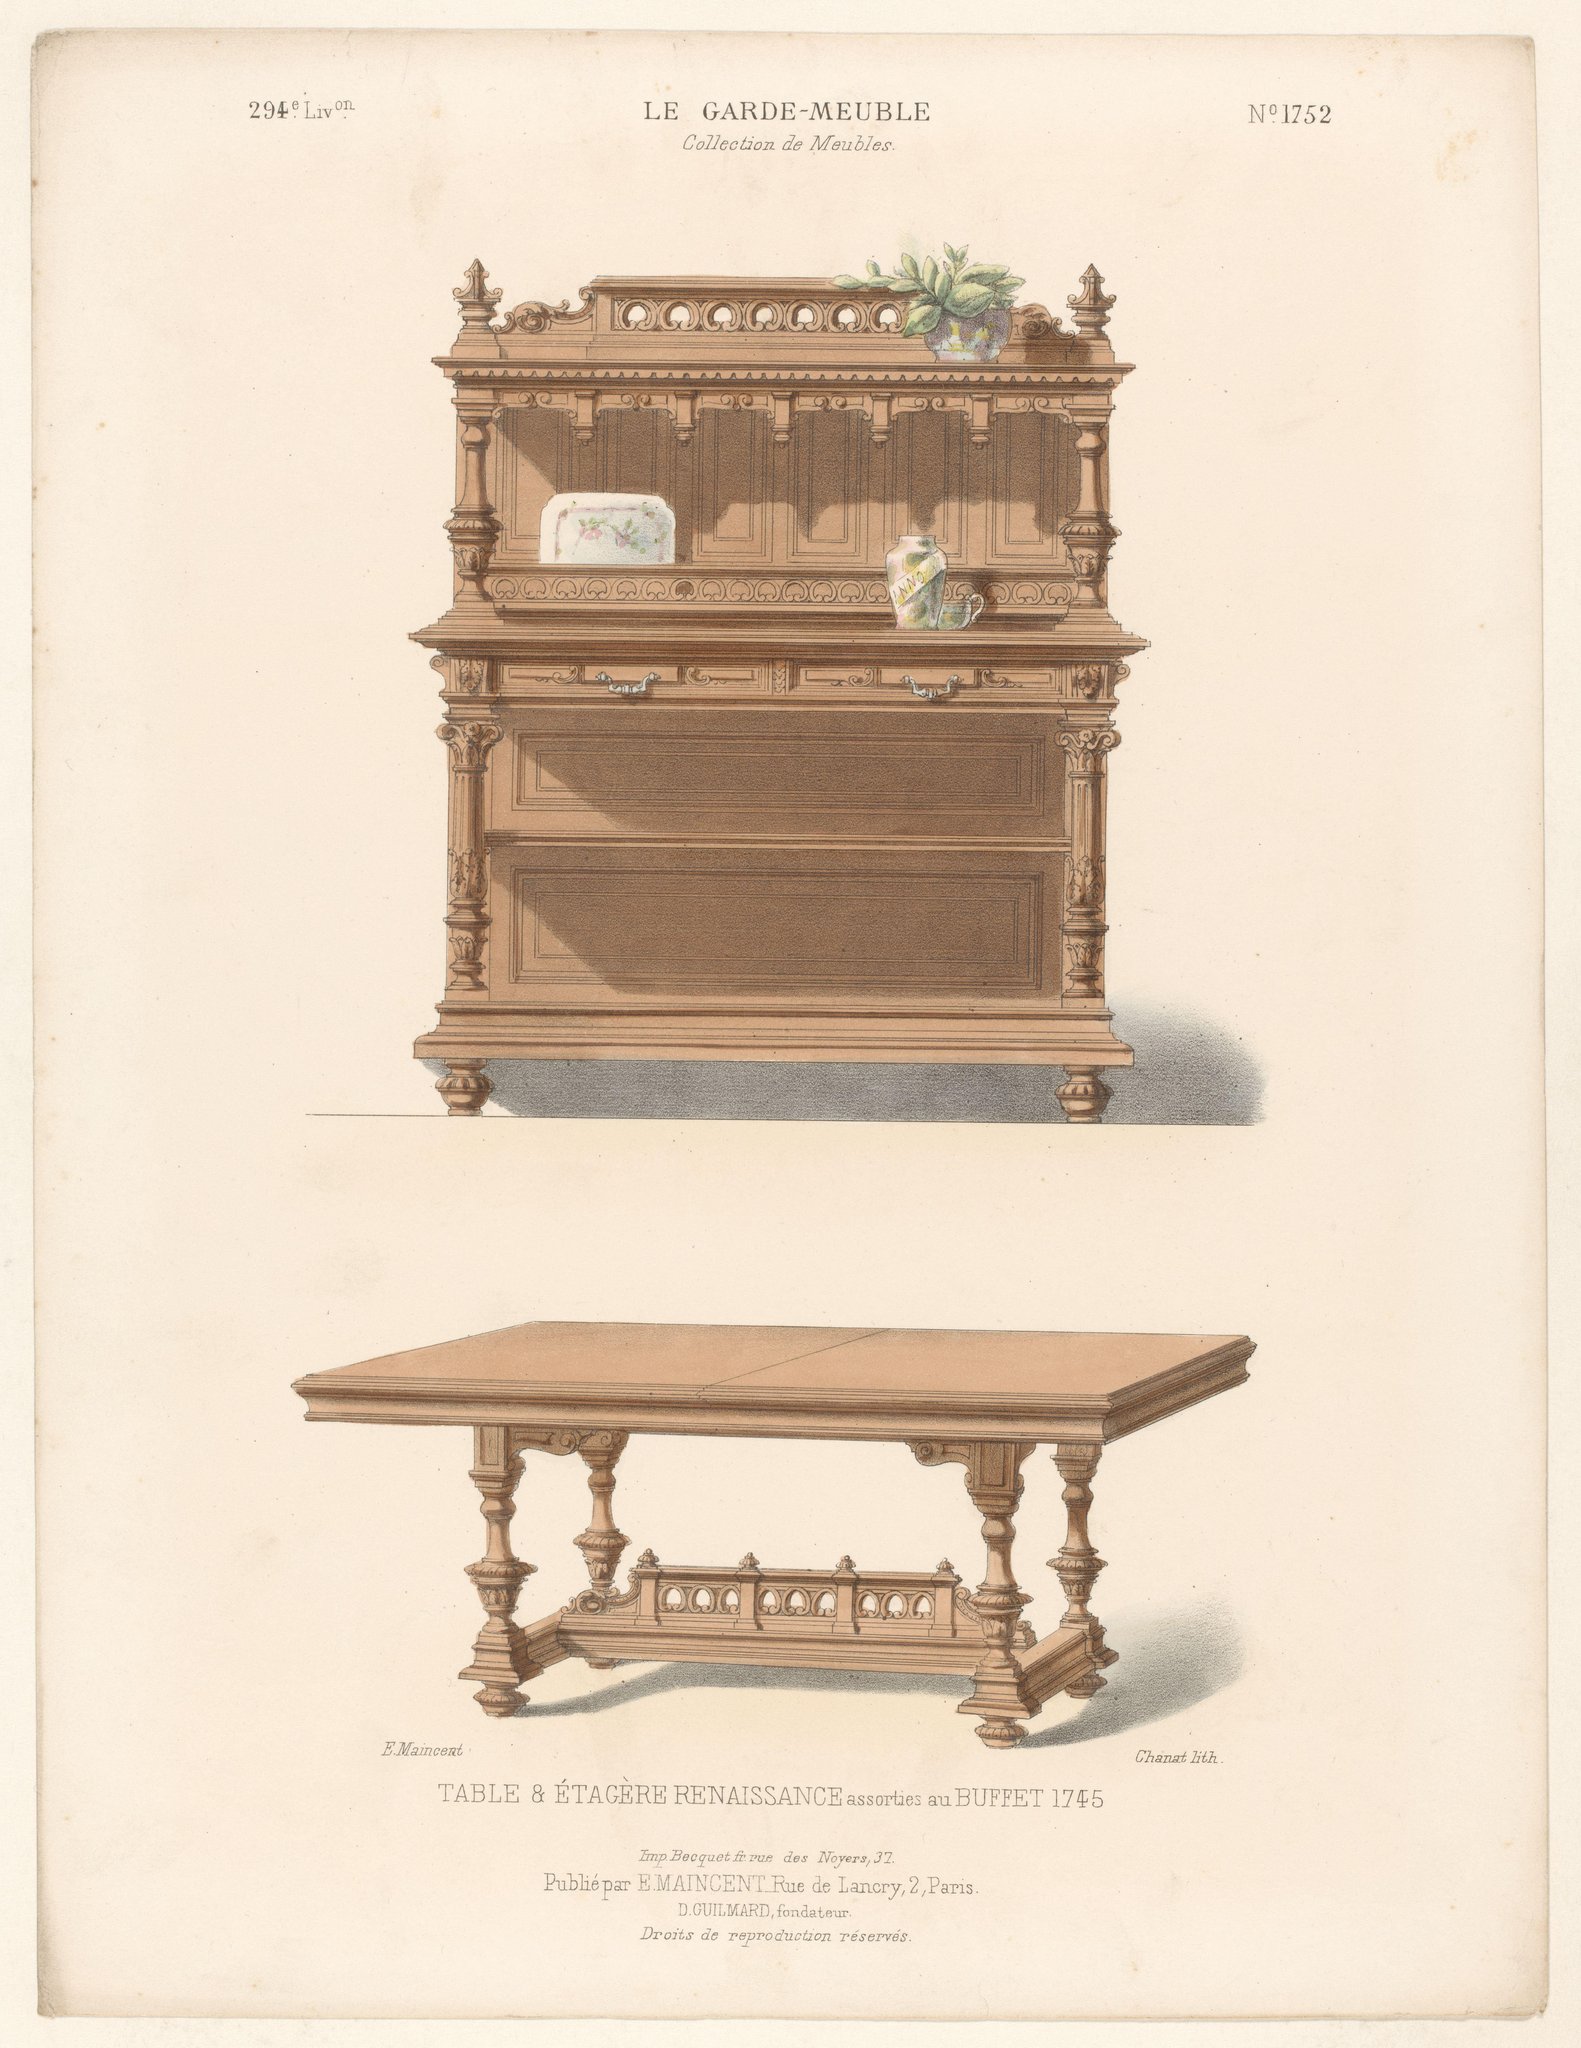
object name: print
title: Le garde-meuble / Collection de Meubles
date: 1885-1895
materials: paper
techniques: hand coloring, lithograph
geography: paris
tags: furniture for storage, table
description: Ieder Livraison in de serie Le Garde-Meuble bevat negen platen: drie 'sièges' (zitmeubels), drie 'meubles' (diverse meubels zoals tafels en kasten) en drie 'tentures' (gordijnen en draperieën).